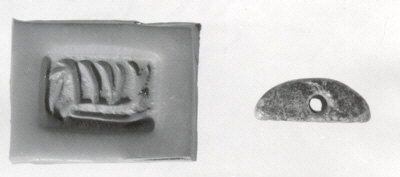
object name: stamp seal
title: Rounded, half-cylinder gable seal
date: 3500-3000 BCE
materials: mineral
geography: northern syria or southeastern anatolia